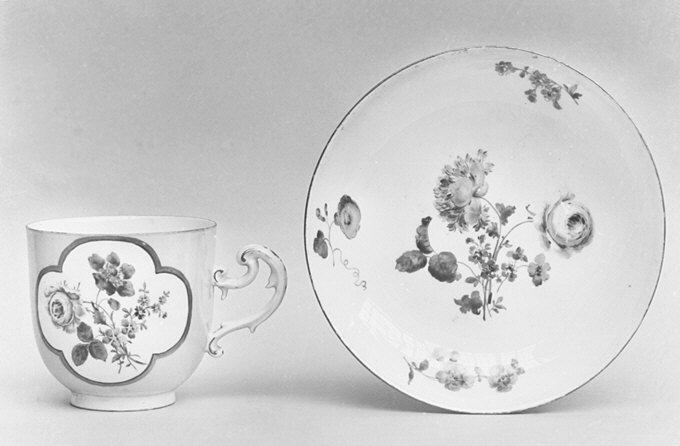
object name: cup and saucer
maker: meissen manufactory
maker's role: manufactory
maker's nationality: german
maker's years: 1710-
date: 1740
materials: hard paste porcelain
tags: flowers